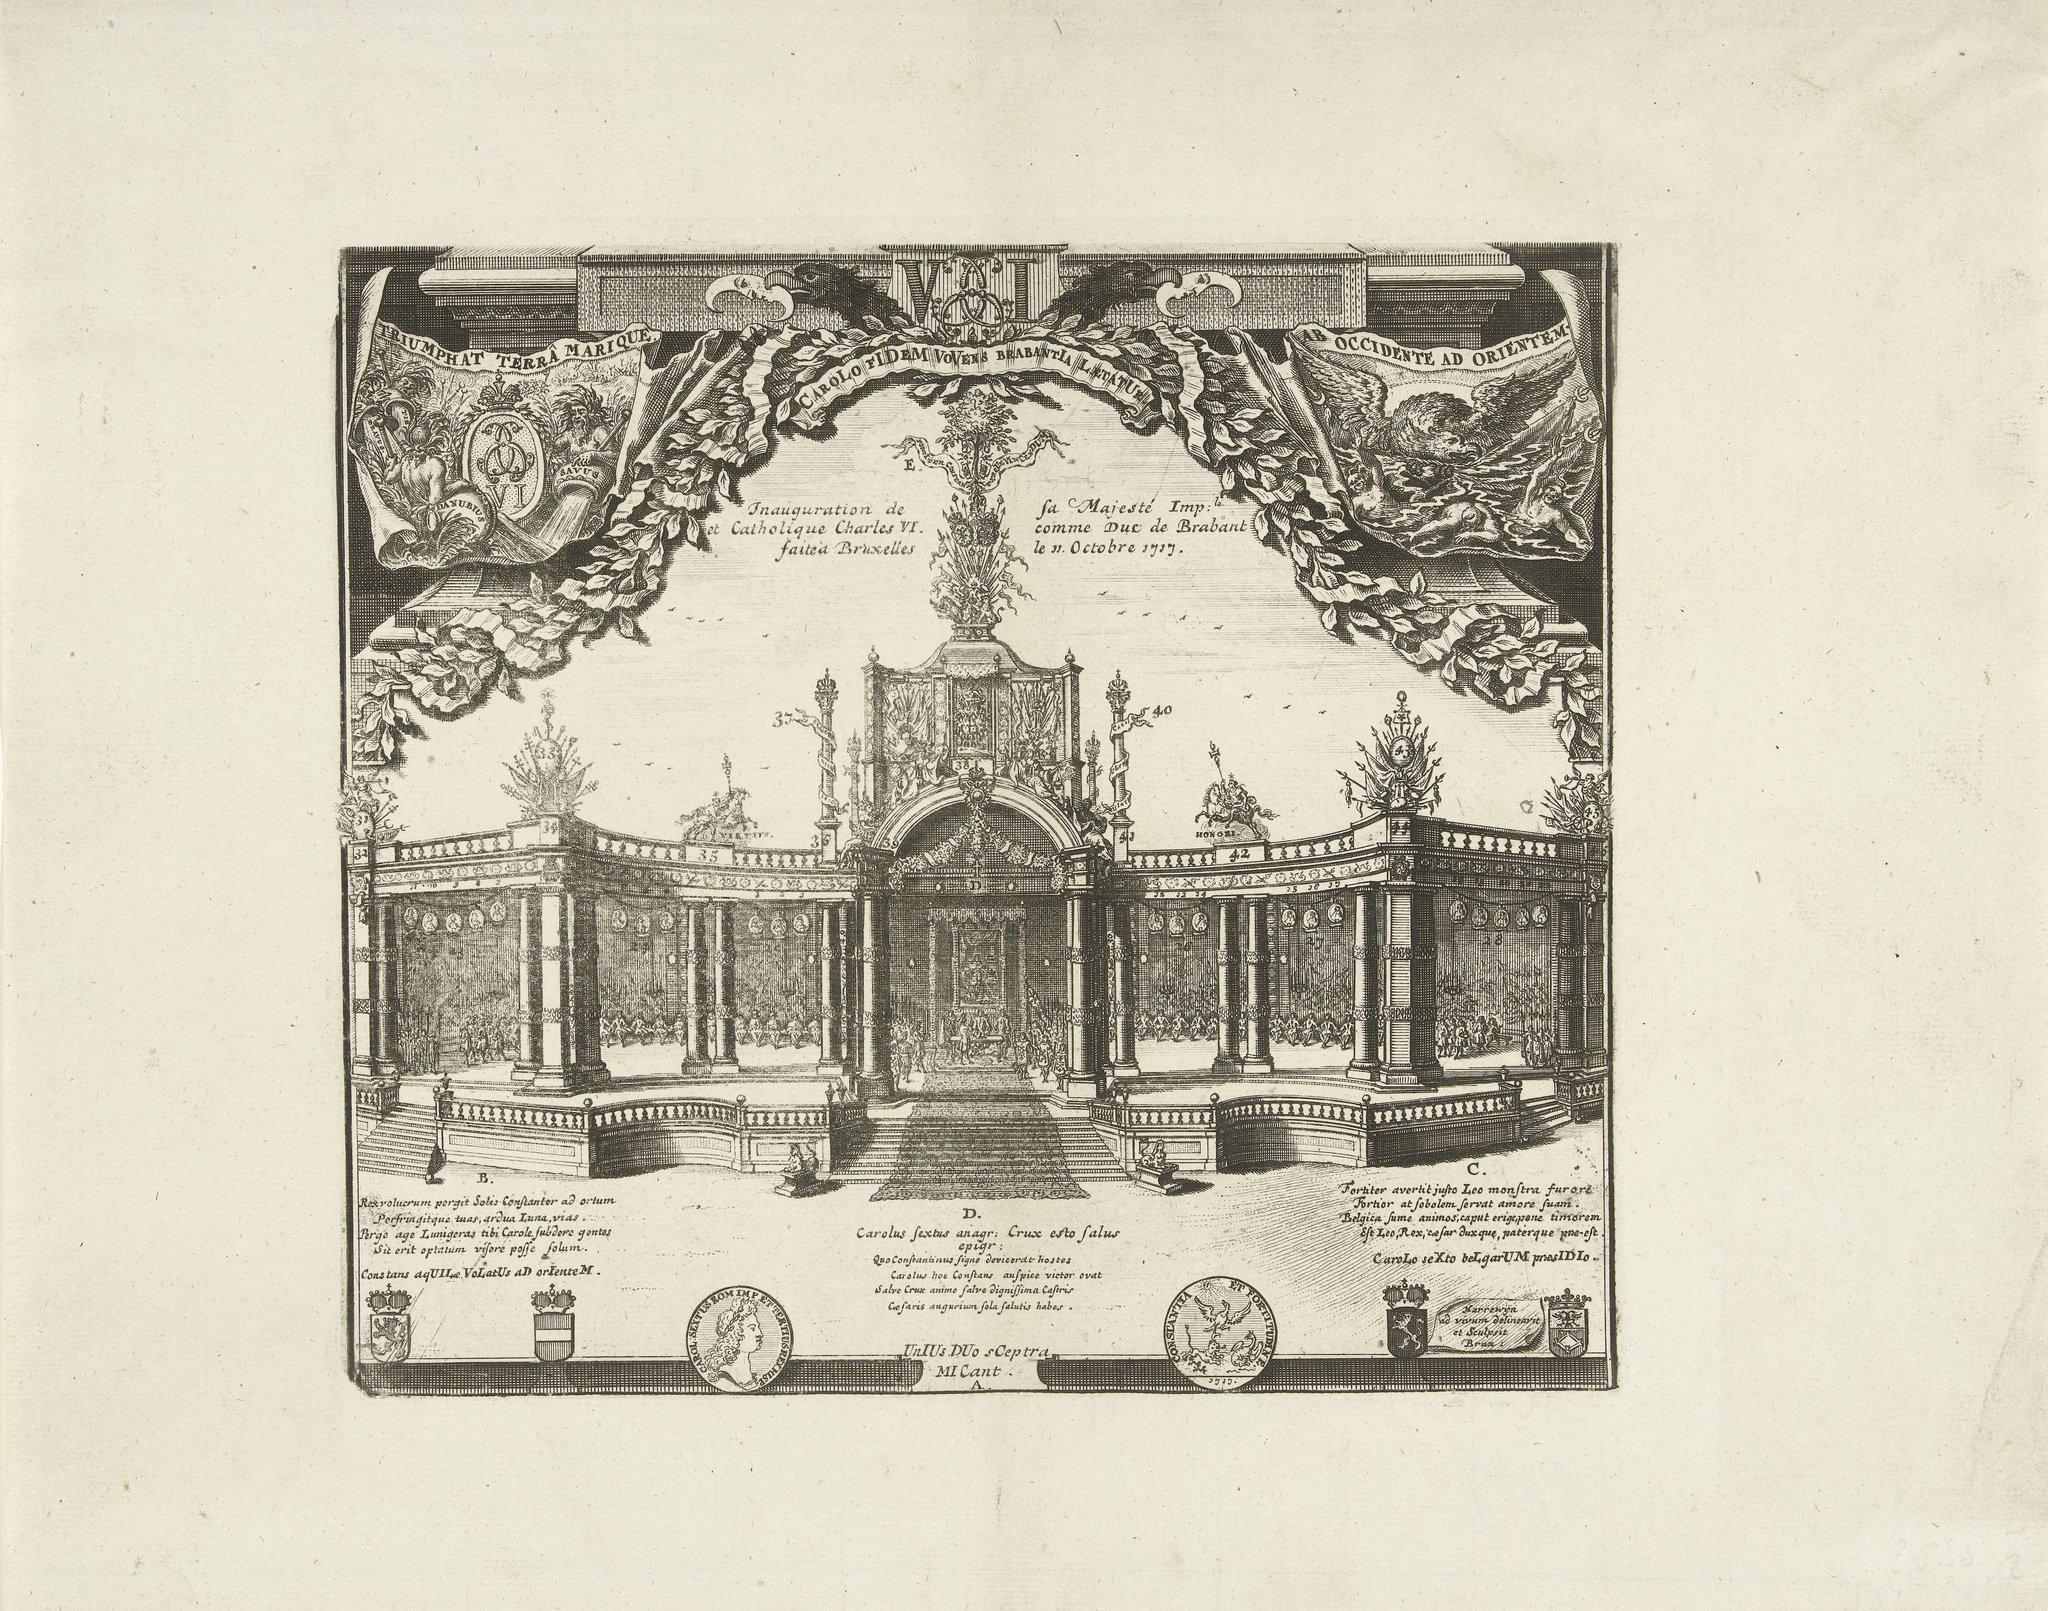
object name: print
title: Inhuldiging van keizer Karel VI als hertog van Brabant te Brussel, 1717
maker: jacobus harrewijn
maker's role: print maker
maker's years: 1660-1740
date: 1717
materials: paper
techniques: etching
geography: brussels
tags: charles vi (holy roman emperor), installation of a ruler, brussels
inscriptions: collector's mark: Lugt 2228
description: Inhuldiging van keizer Karel VI als hertog van Brabant te Brussel, 11 oktober 1717. Ceremonie op een podium met ereboog en zuilen, opgericht op de Grote Markt voor het Stadhuis. Bovenaan vaandels met emblemen, onderaan wapens en een penning.